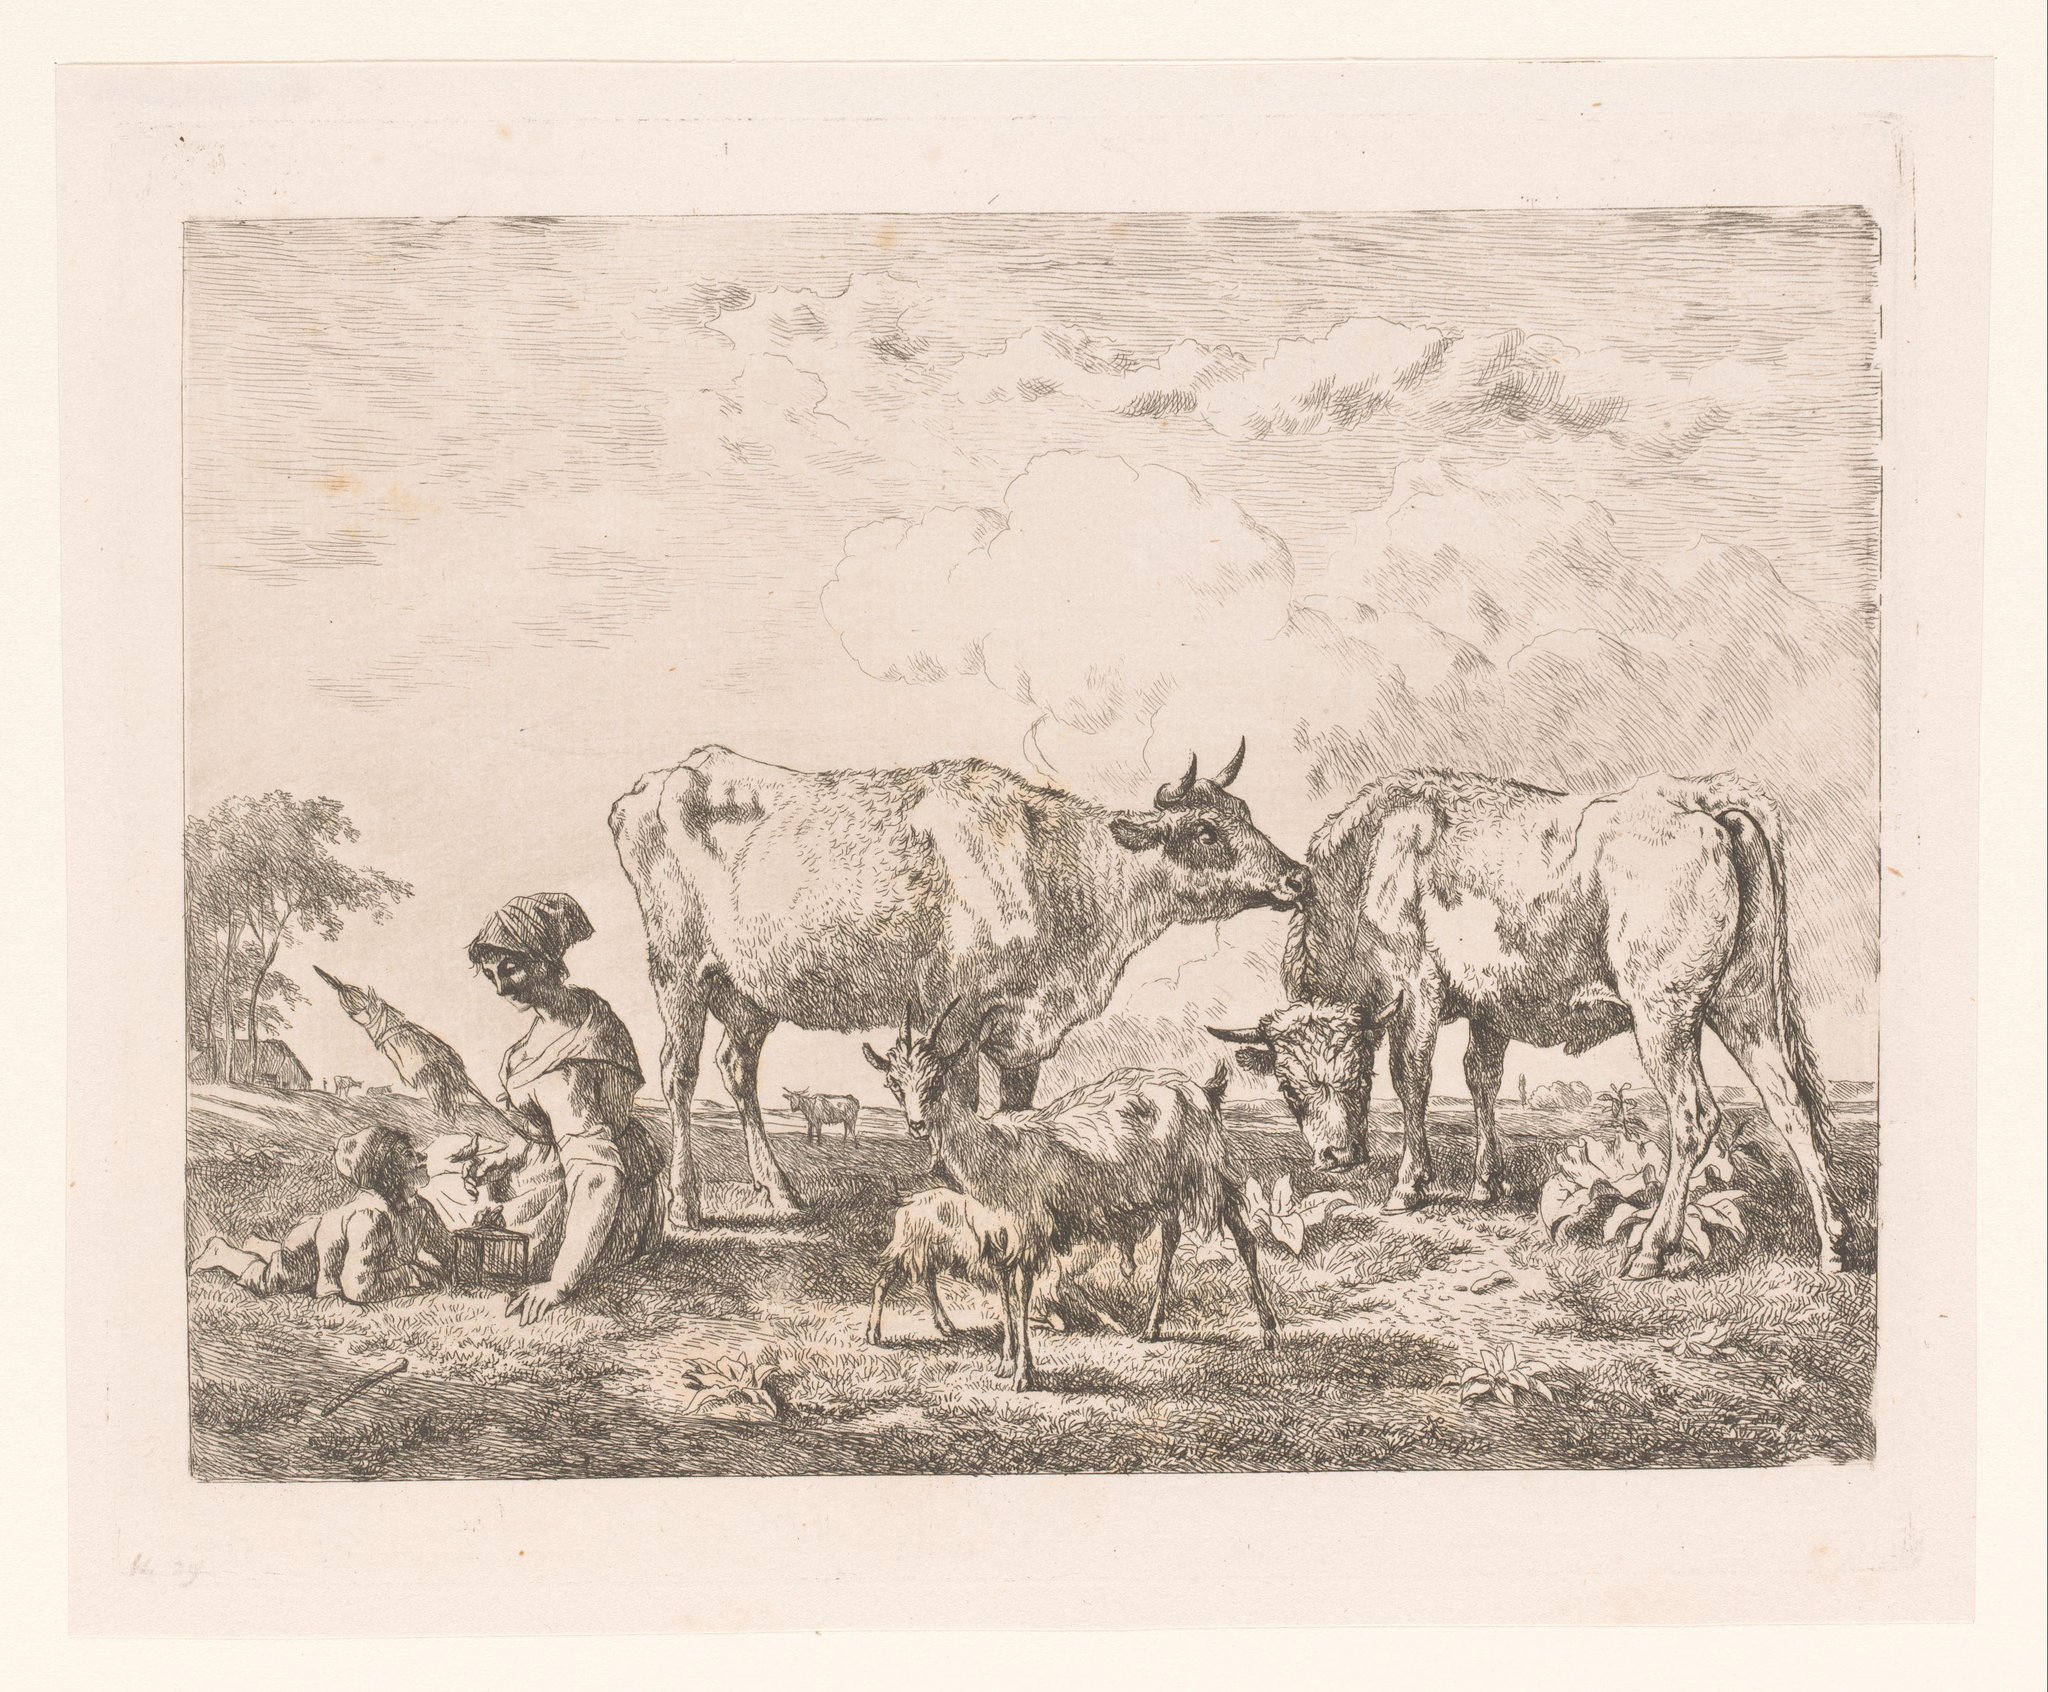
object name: print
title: Spinster met kind en vogel zit tussen de koeien en geiten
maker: jean louis demarne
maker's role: draughtsman, painter, print maker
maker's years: 1752-1829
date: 1762-1829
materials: paper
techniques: etching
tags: cattle, birds, mother and baby or young child, spinning (manufacture of yarn)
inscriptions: collector's mark: Lugt 2228